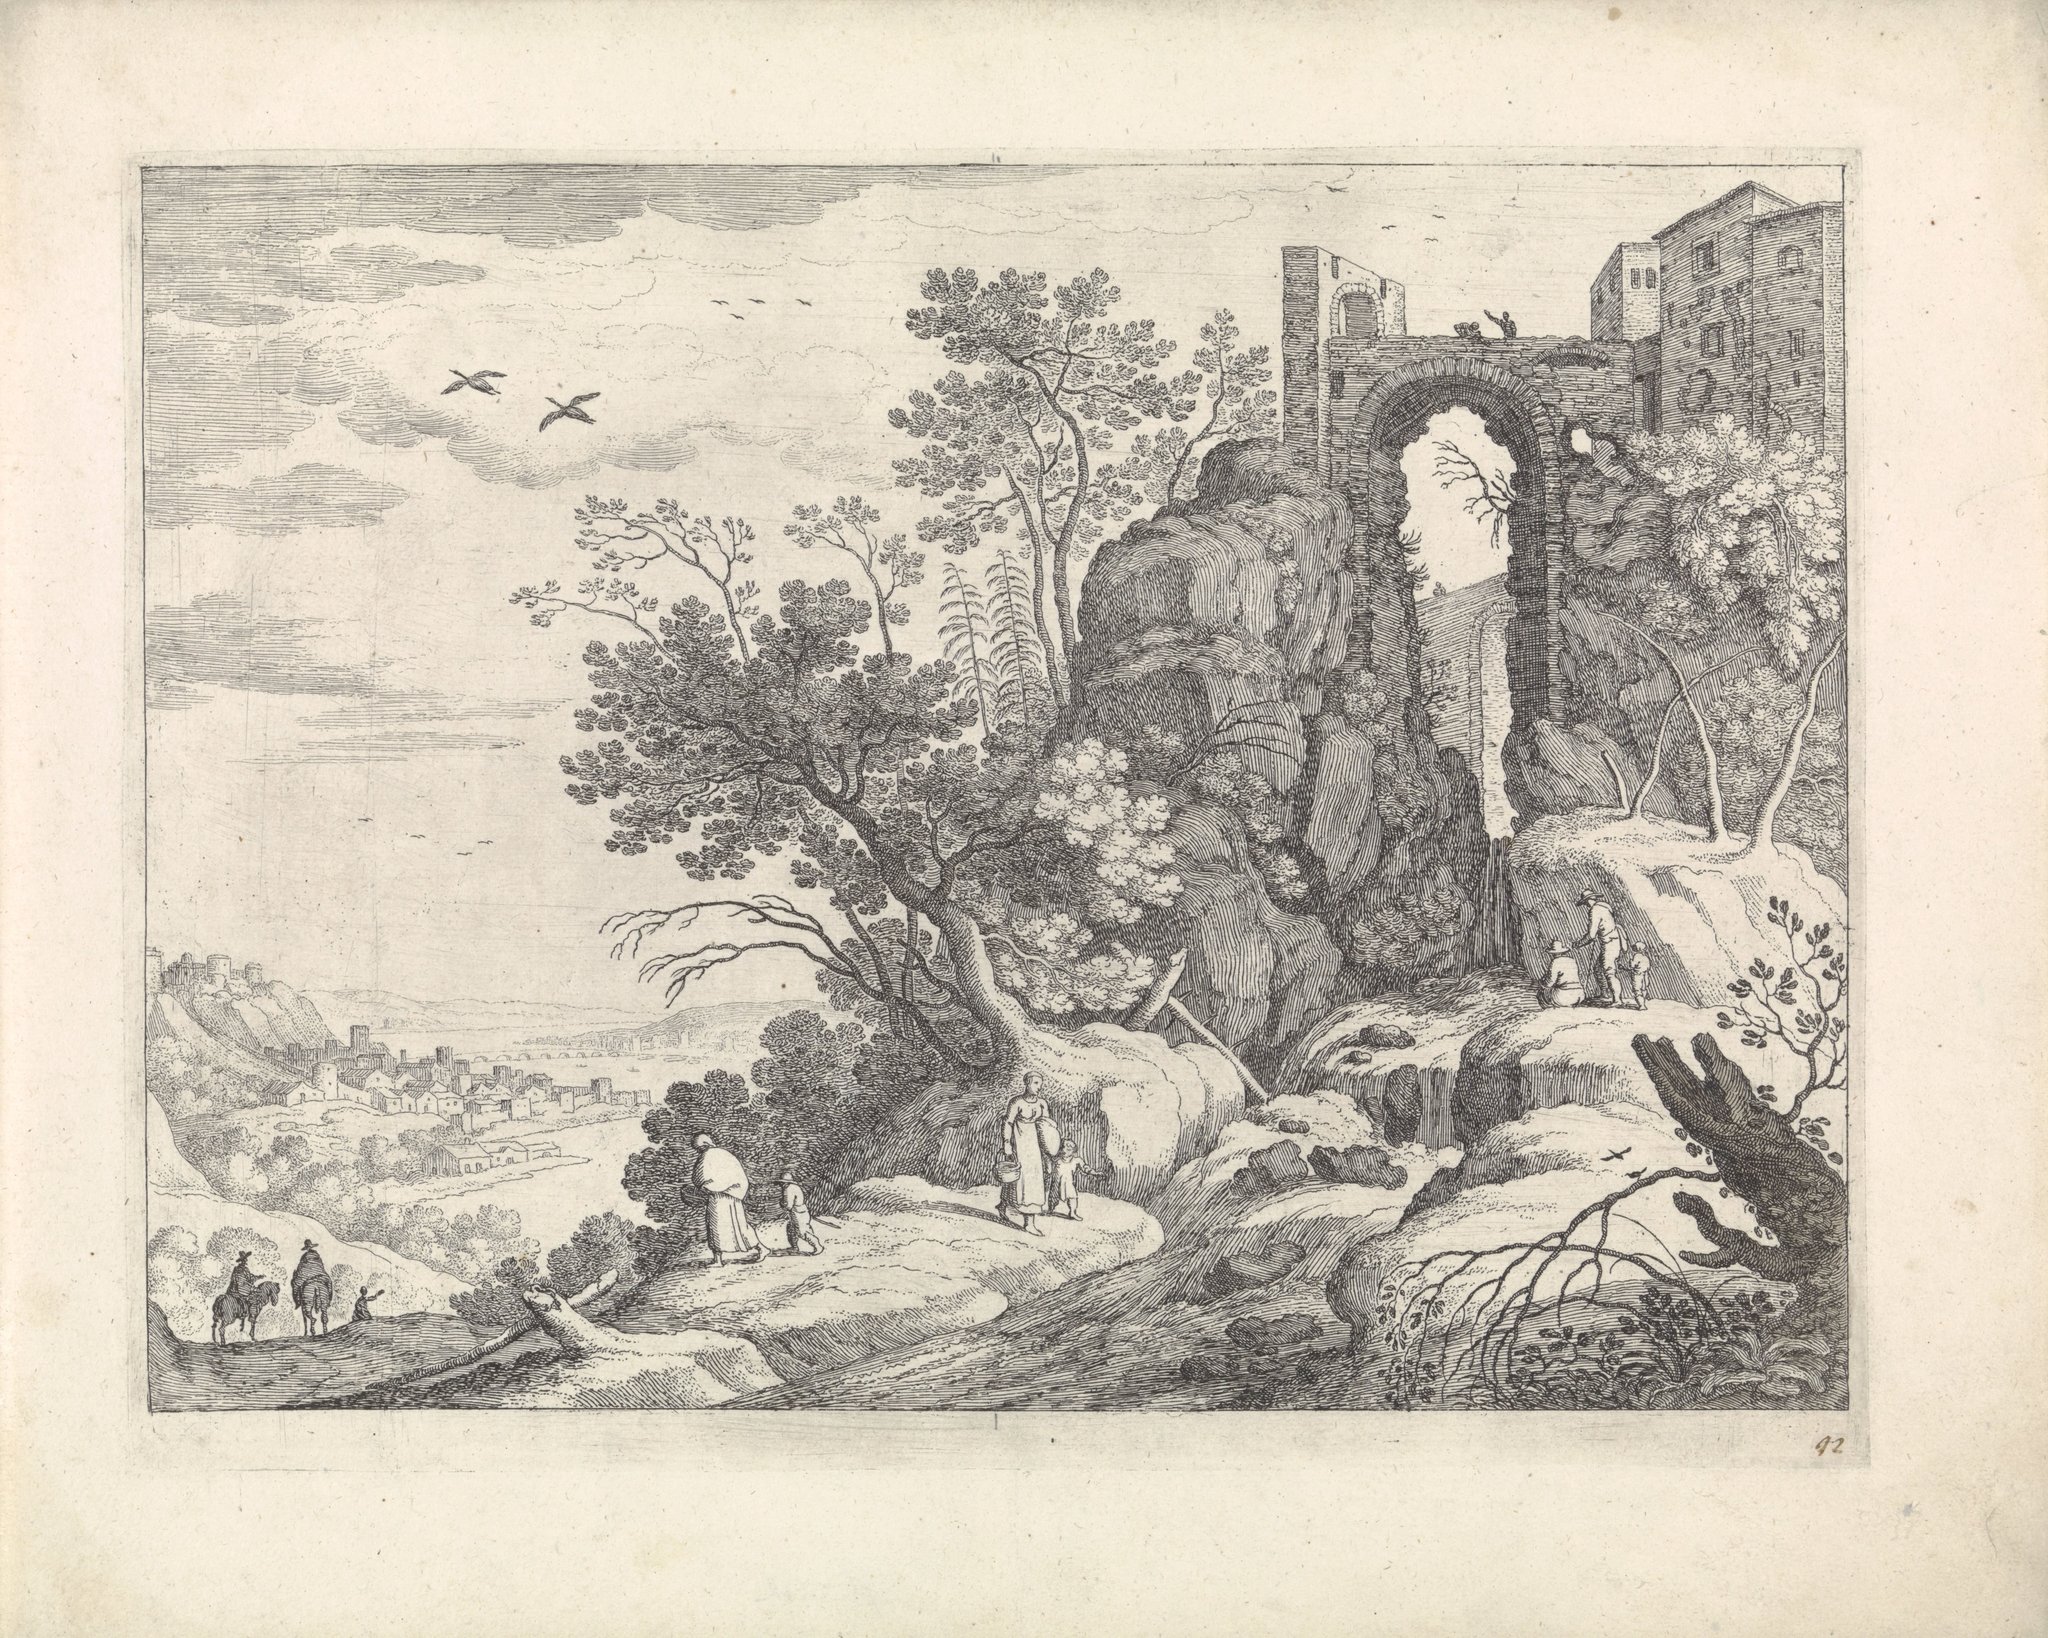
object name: print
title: Rivier en waterval onder een hoge brug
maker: guilliam van nieulandt (ii)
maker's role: draughtsman, print maker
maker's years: 1584-1635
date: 1594-1635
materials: paper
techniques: brush, engraving, etching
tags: waterfall, landscape with bridge, viaduct or aqueduct (+ city(-scape) with figures, staffage)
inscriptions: collector's mark: Lugt 2228, collector's mark: Lugt 2760, inscription: ‘42’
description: Onder een hoge brug, waarop twee figuren staan, stroomt een waterval en rivier. Aan weerszijden staan en lopen figuren. Links in de diepte ligt een stad aan een rivier.